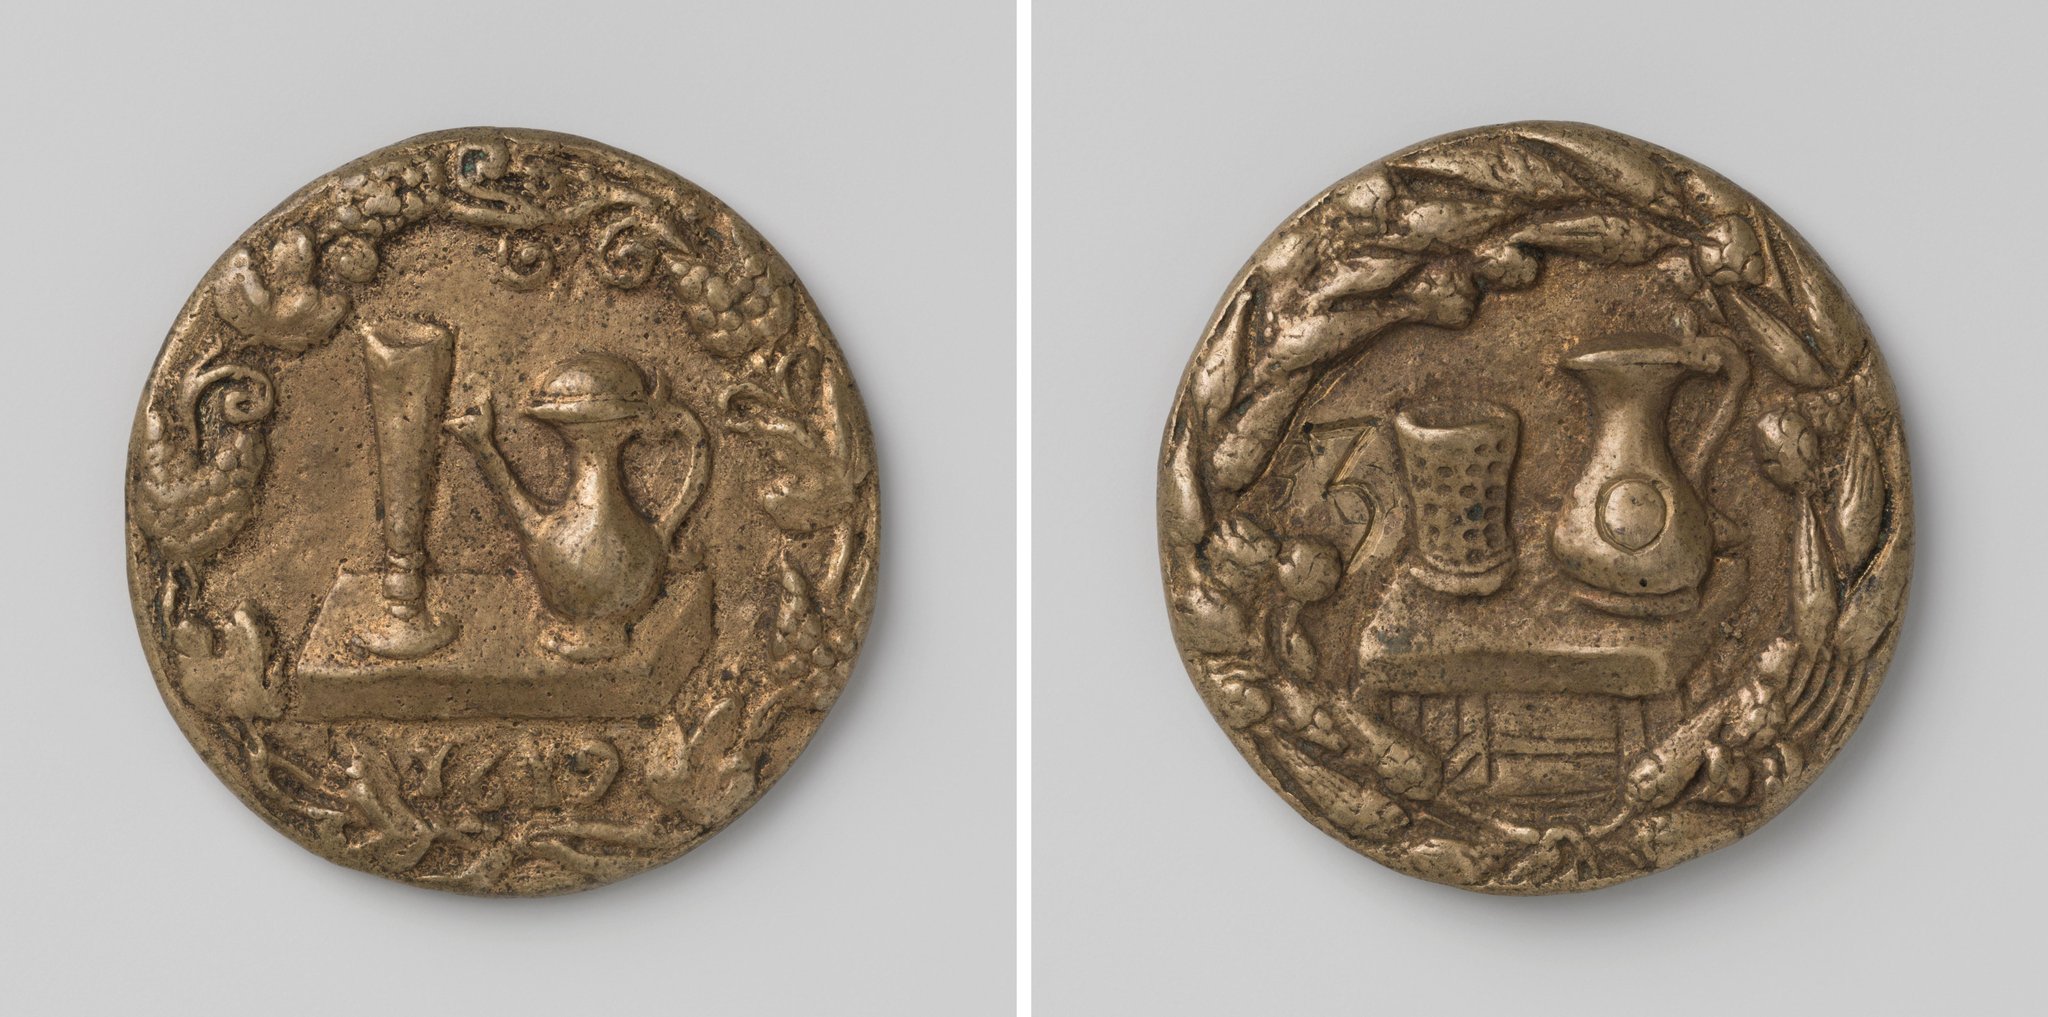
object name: medal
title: Wijnheren- en biertappersgilde van Middelburg, gildepenning met no. 3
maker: Anonymous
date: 1619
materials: brass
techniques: casting, engraving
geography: middelburg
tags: middelburg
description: Messing penning. Voorzijde: tuitkan en fluitglas boven jaartal binnen krans van bladeren en druiven. Keerzijde: bierkan en -glas op tafel; links: cijfer 3 binnen krans van bladeren, druiven en bloemen